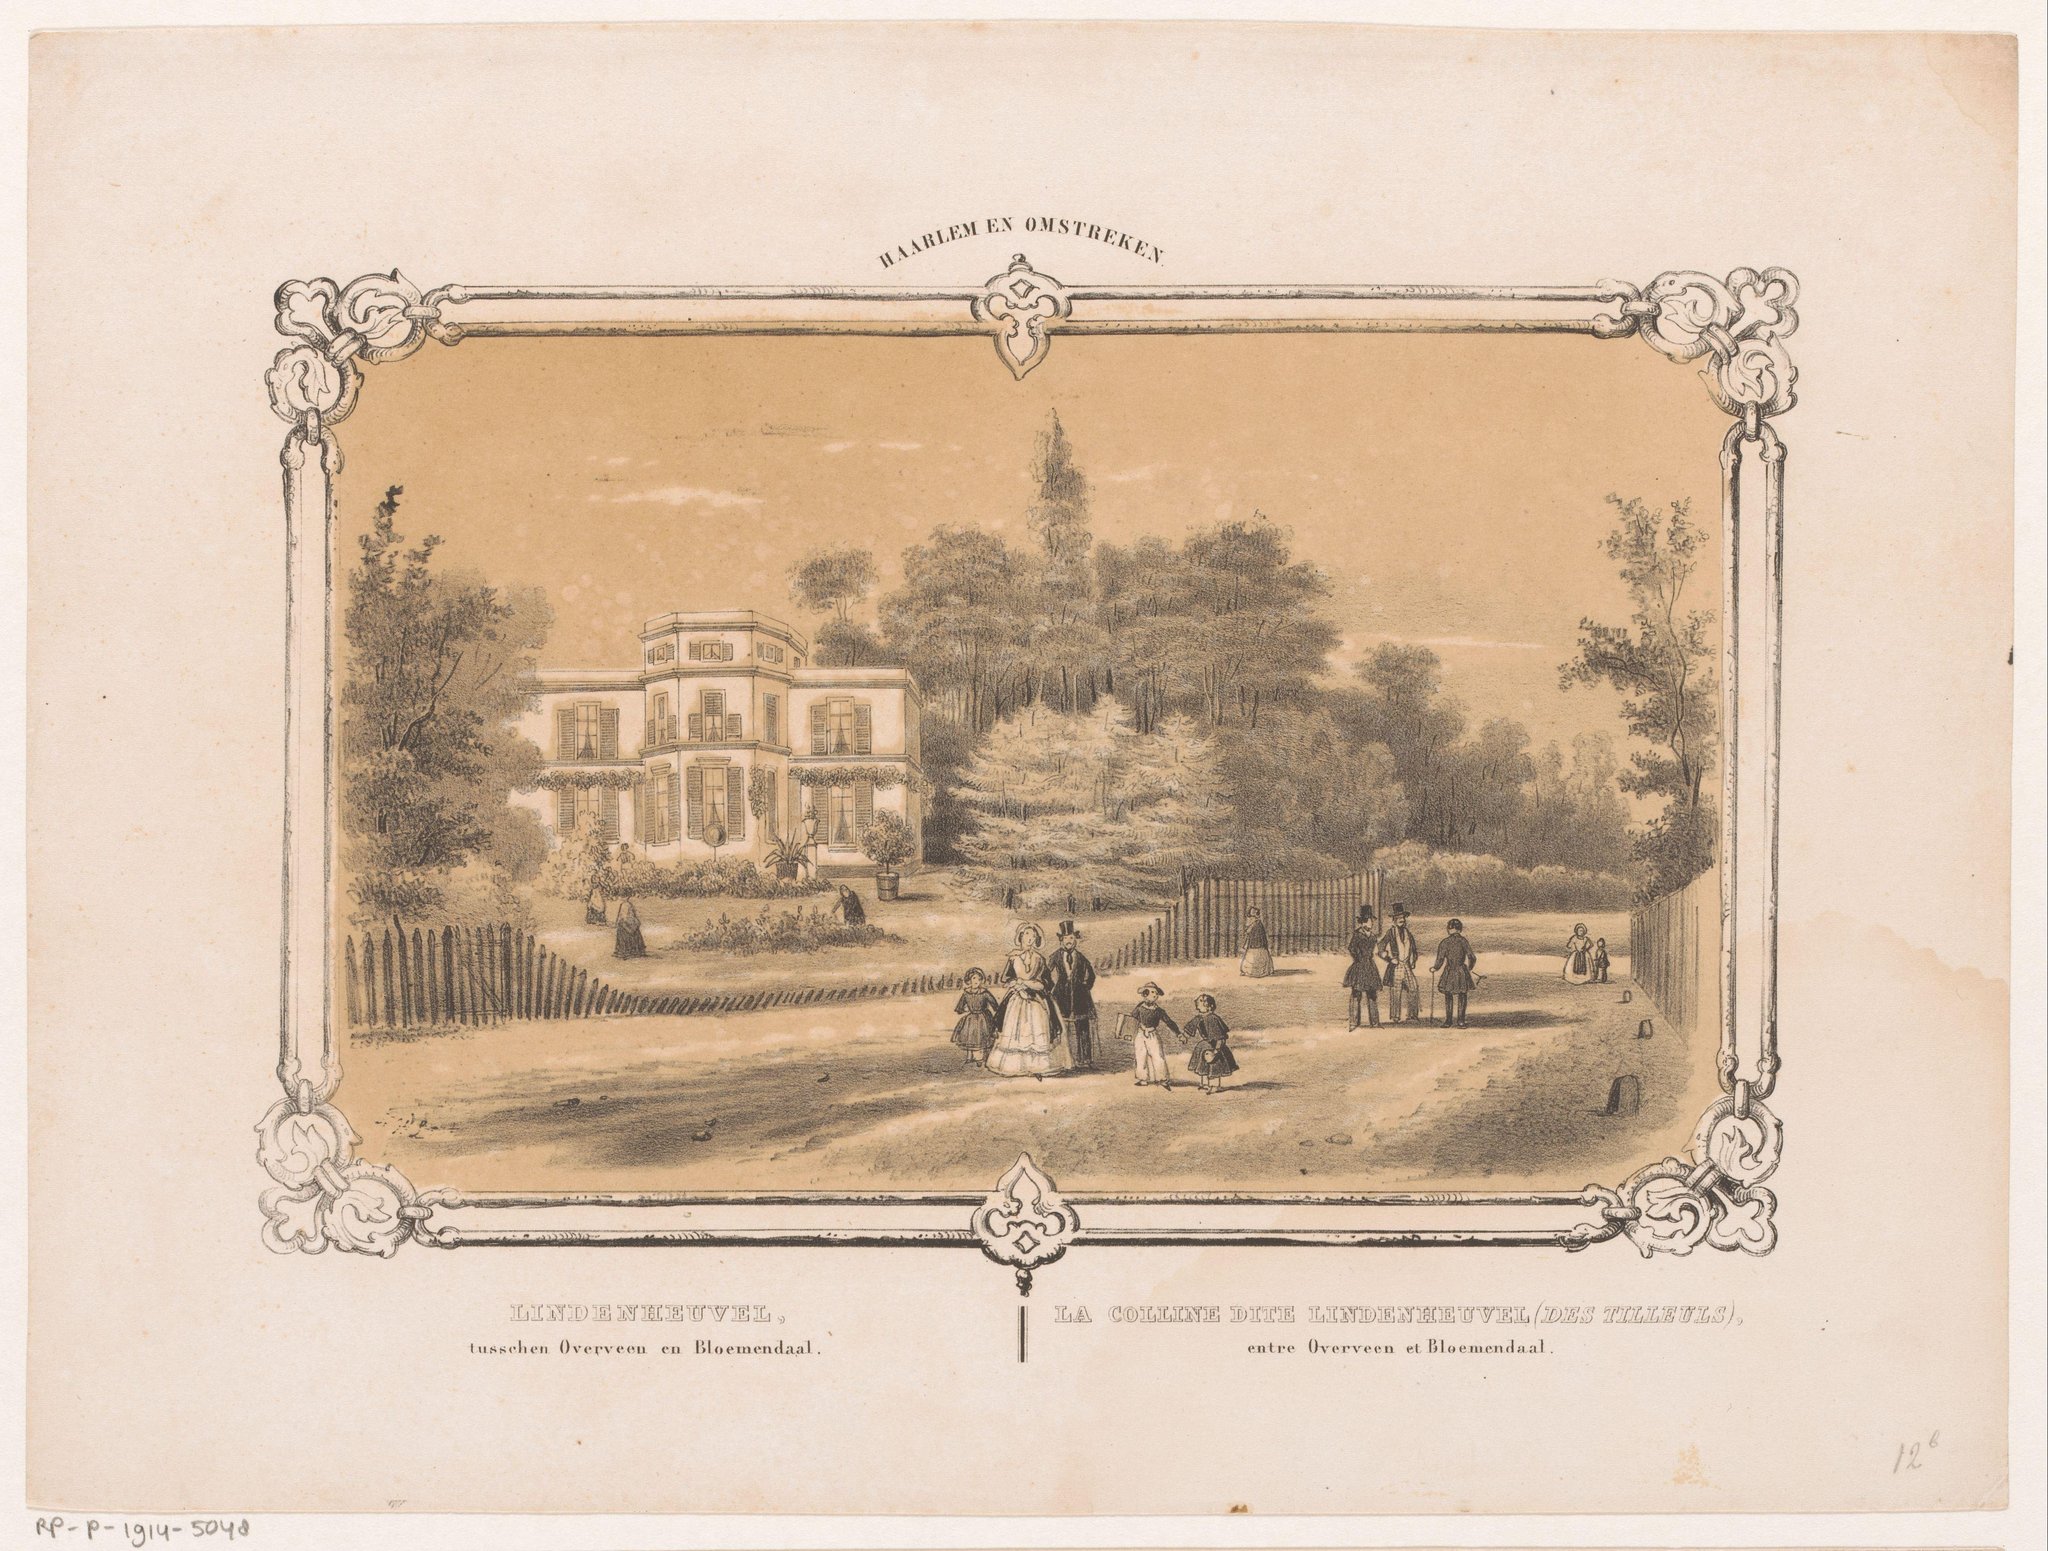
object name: print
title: Lindenheuvel tusschen Overveen en Bloemendaal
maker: hendrik wilhelmus last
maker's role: print maker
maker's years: 1817-1873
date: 1827-1873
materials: paper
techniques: tone lithography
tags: farm or solitary house in landscape (+ city(-scape) with figures, staffage), country-house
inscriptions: collector's mark: Lugt 2228